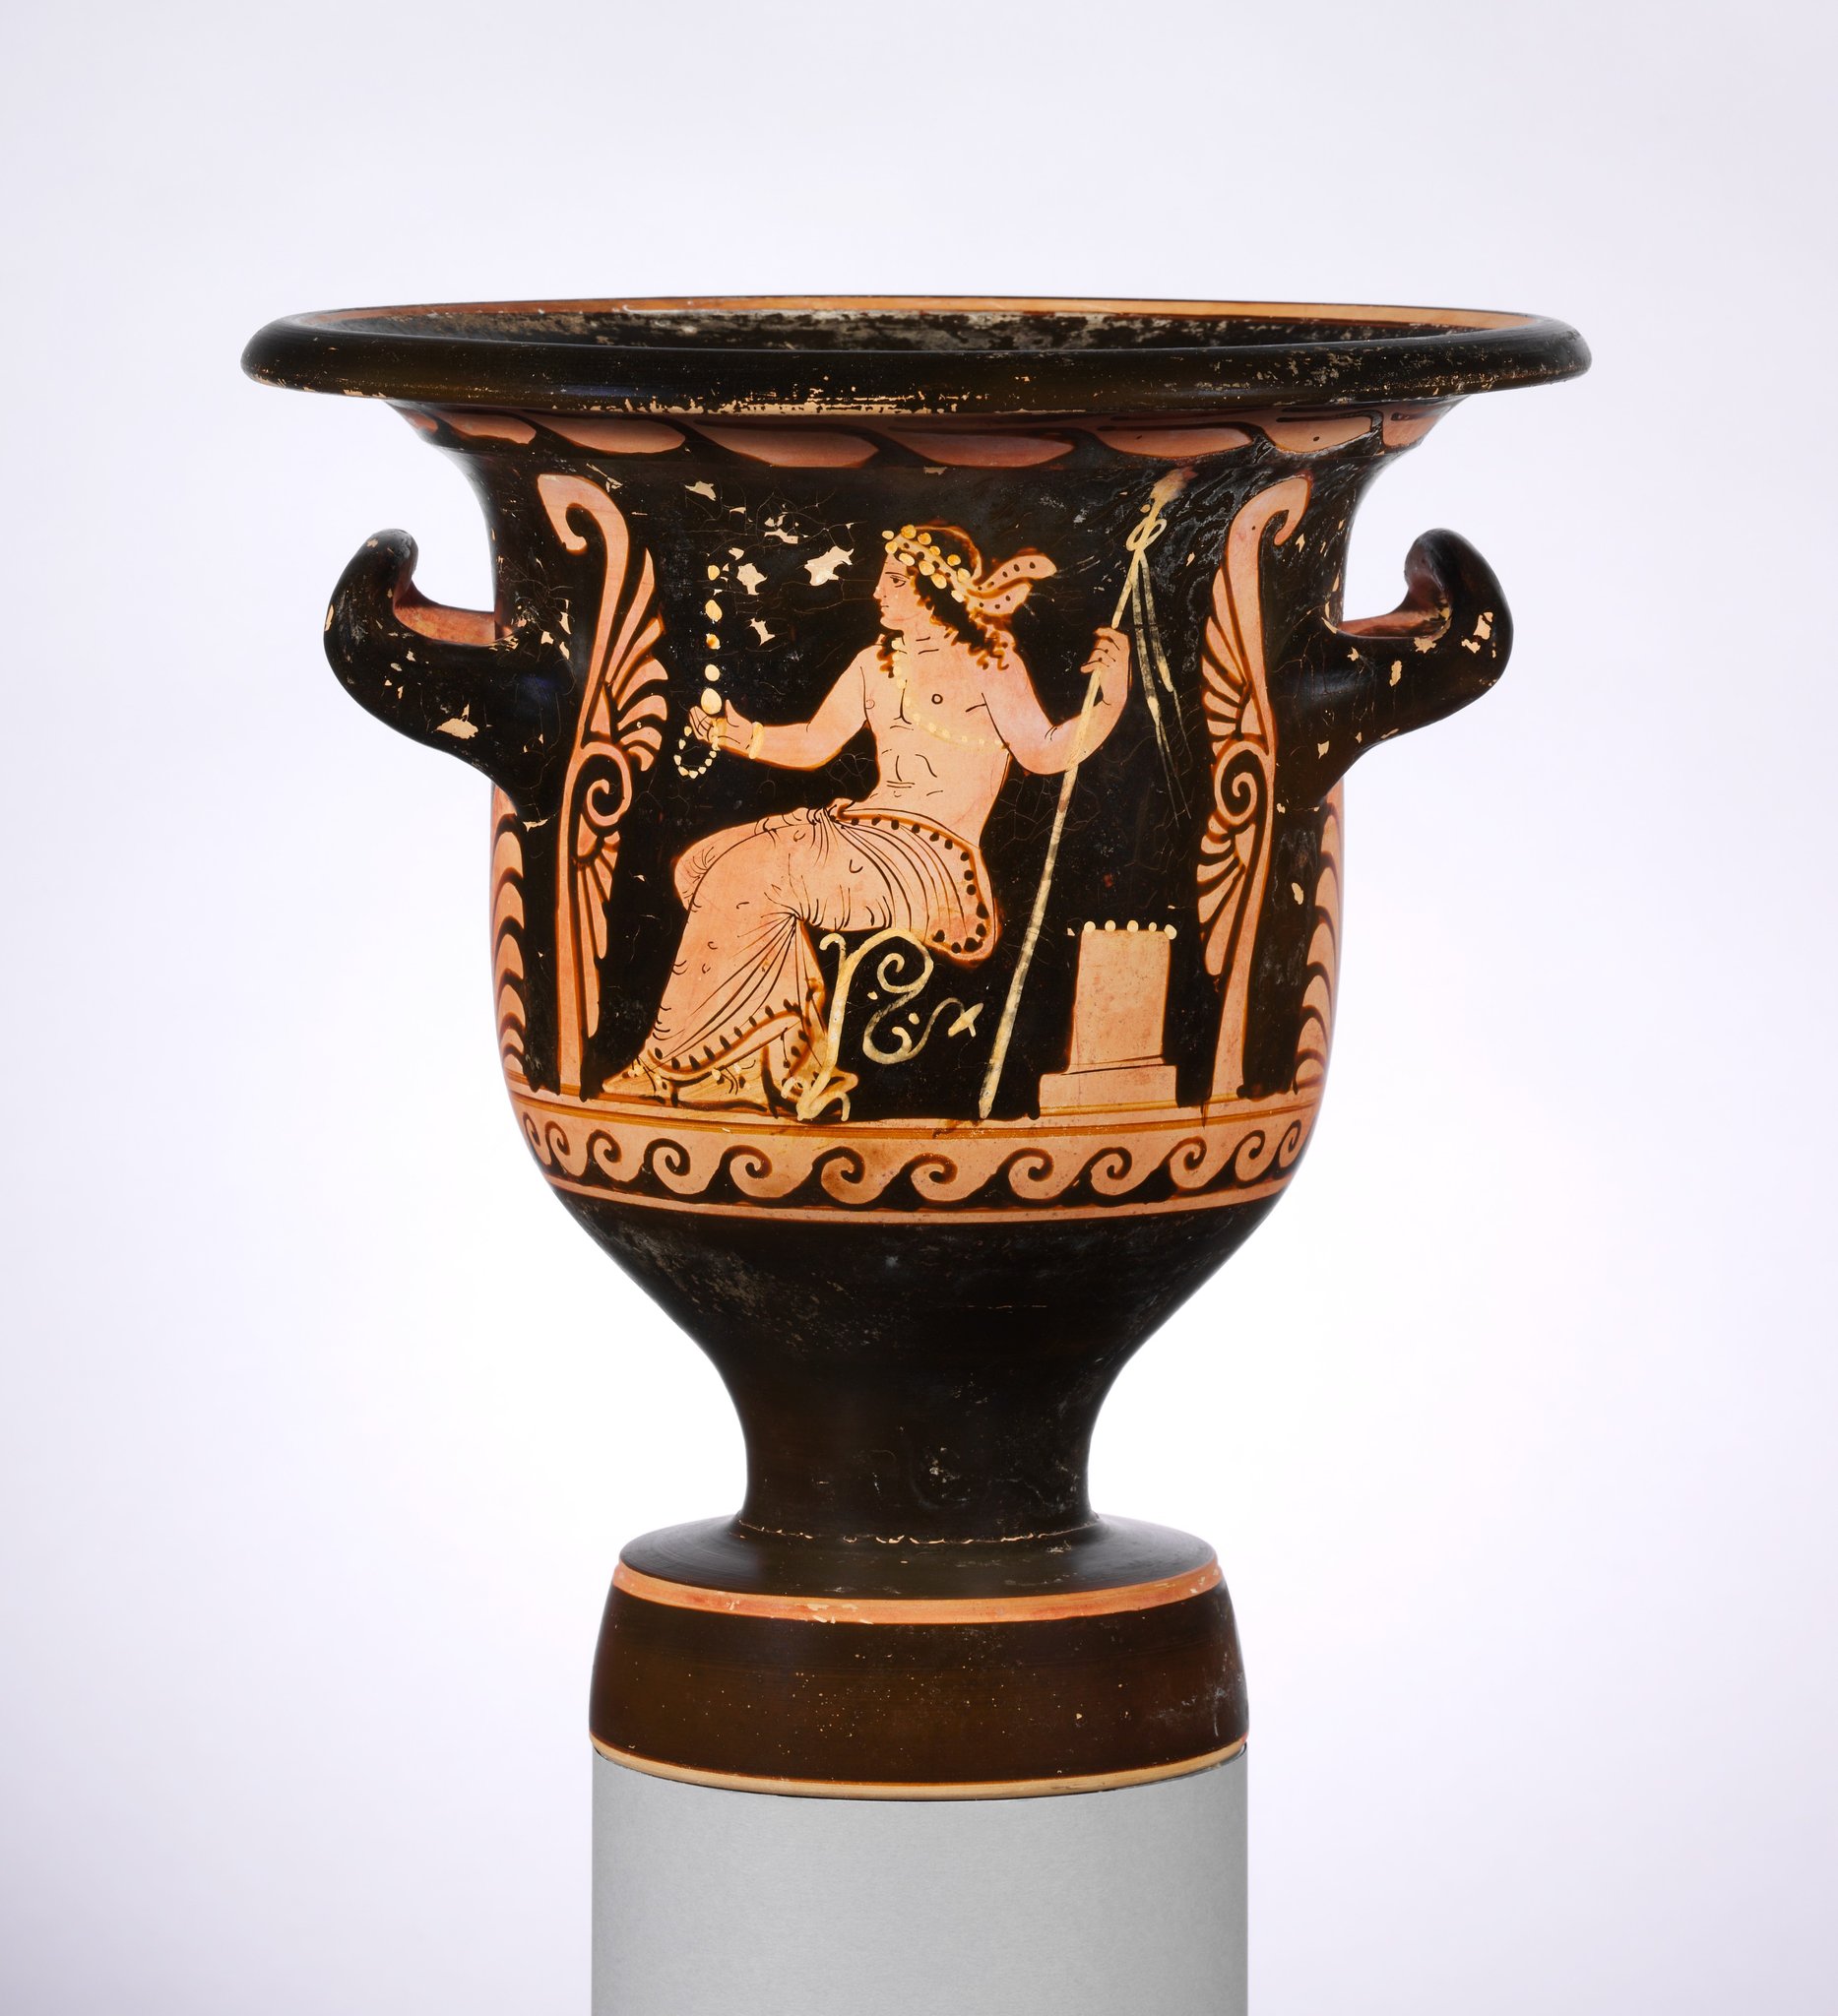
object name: bell krater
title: Terracotta bell-krater (mixing bowl)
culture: greek, paestan or south italian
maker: python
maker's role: artist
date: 350-325 BCE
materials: terracotta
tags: male nudes,dionysus,satyrs